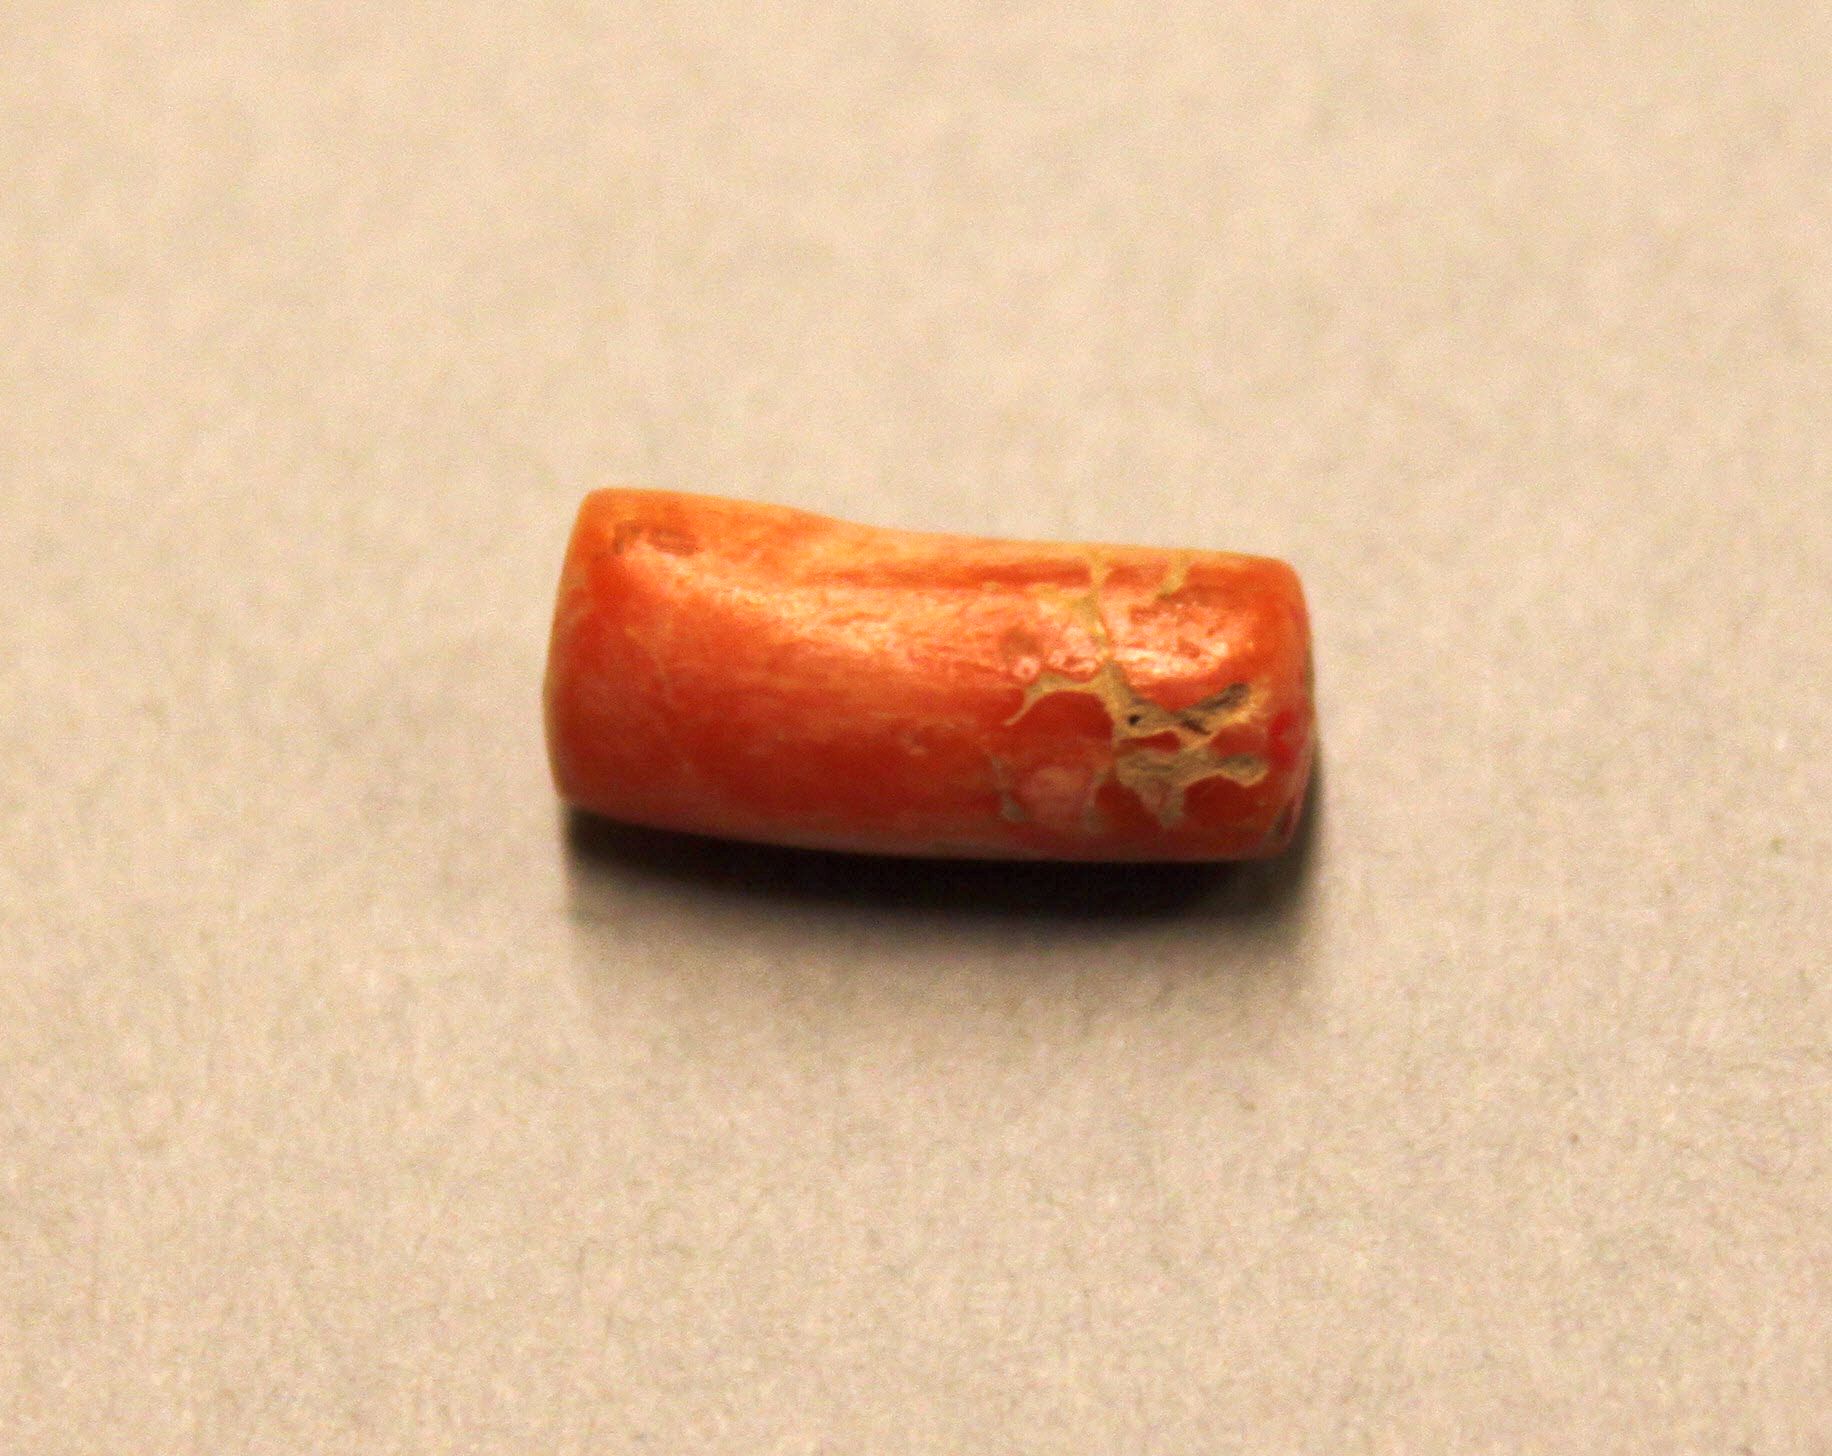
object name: bead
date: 701-1200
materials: stone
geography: iran